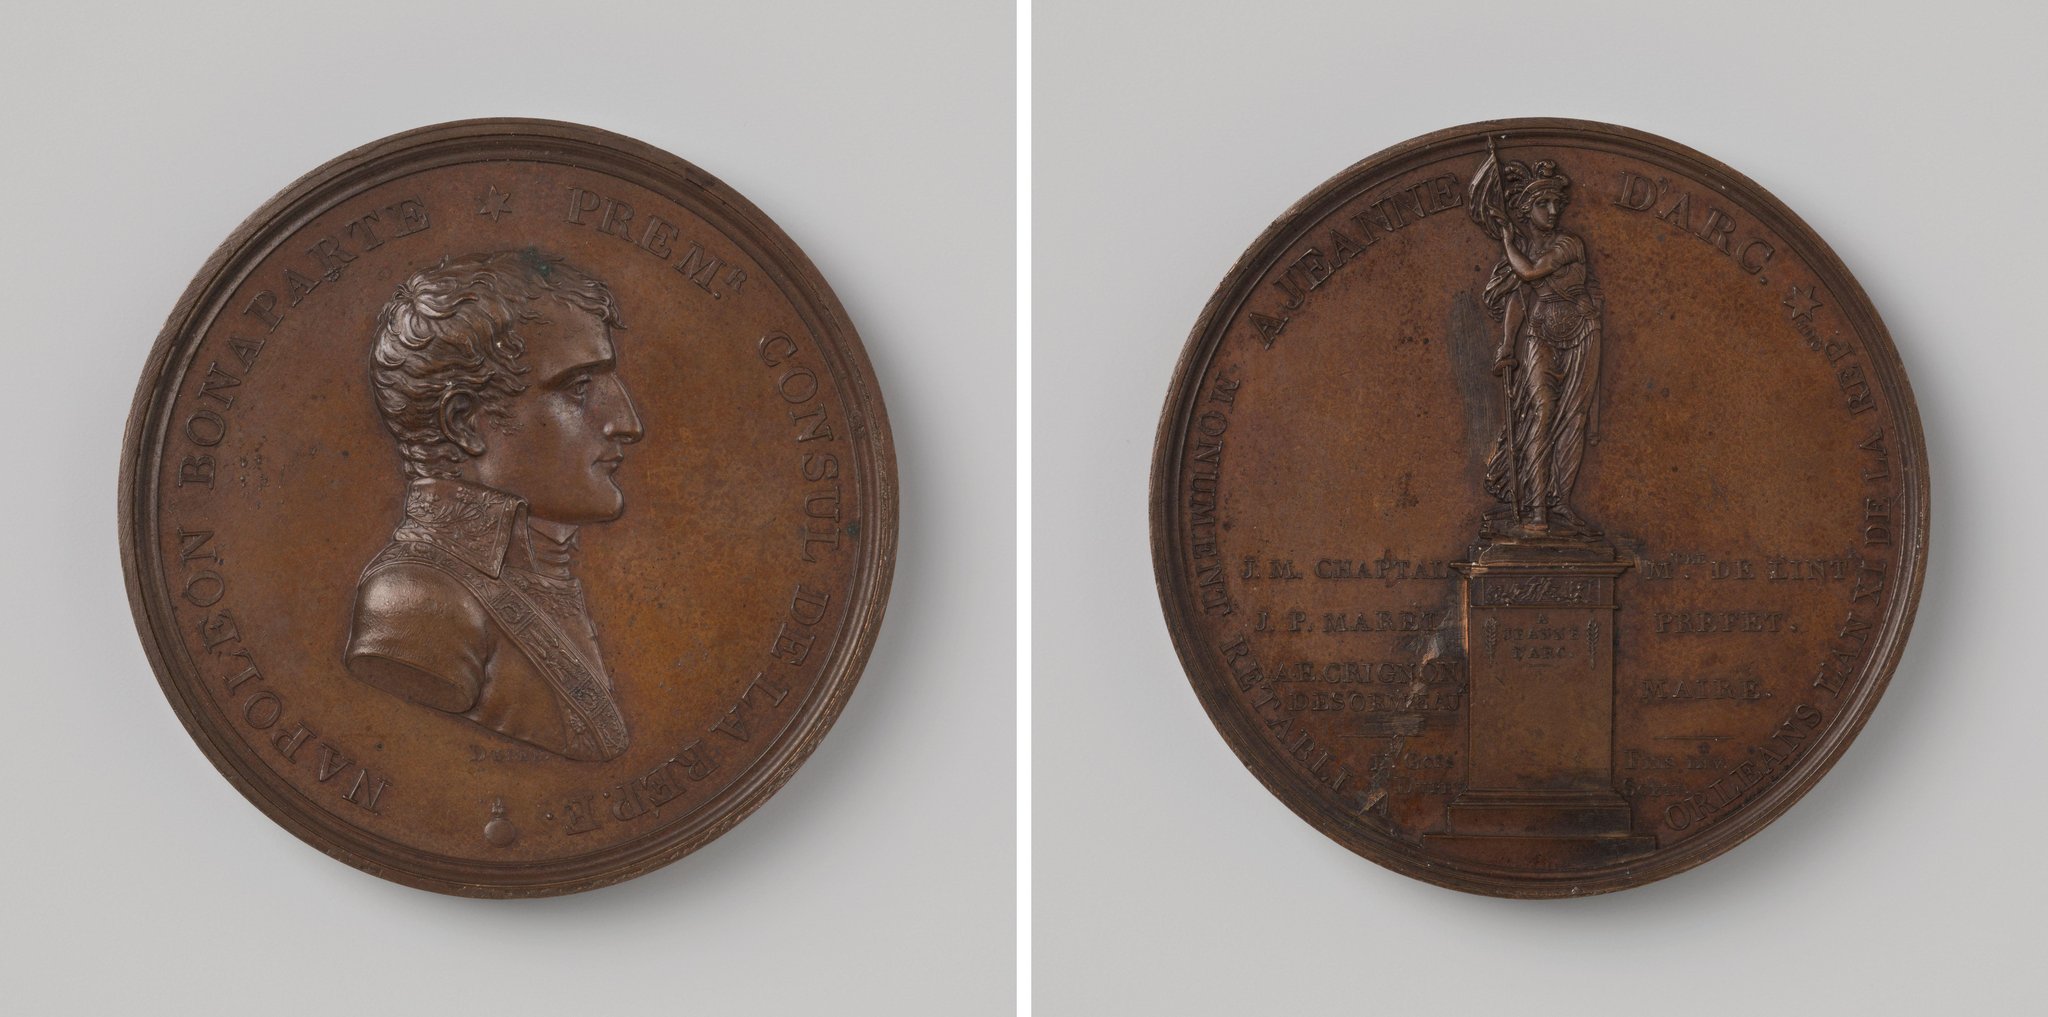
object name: history medal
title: Oprichting van een standbeeld voor Jeanne d'Arc te Orleans, ter ere van Napoleon Bonaparte, premier consul van Frankrijk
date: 1803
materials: bronze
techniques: striking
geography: paris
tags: napoleon i (emperor of the french), politician, jean-antoine chaptal, mayor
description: Bronzen penning. Voorzijde: borststuk man binnen omschrift. Keerzijde: standbeeld van Jeanne d'Arc met zwaard en vaandel in handen tussen opschriften binnen omschrift